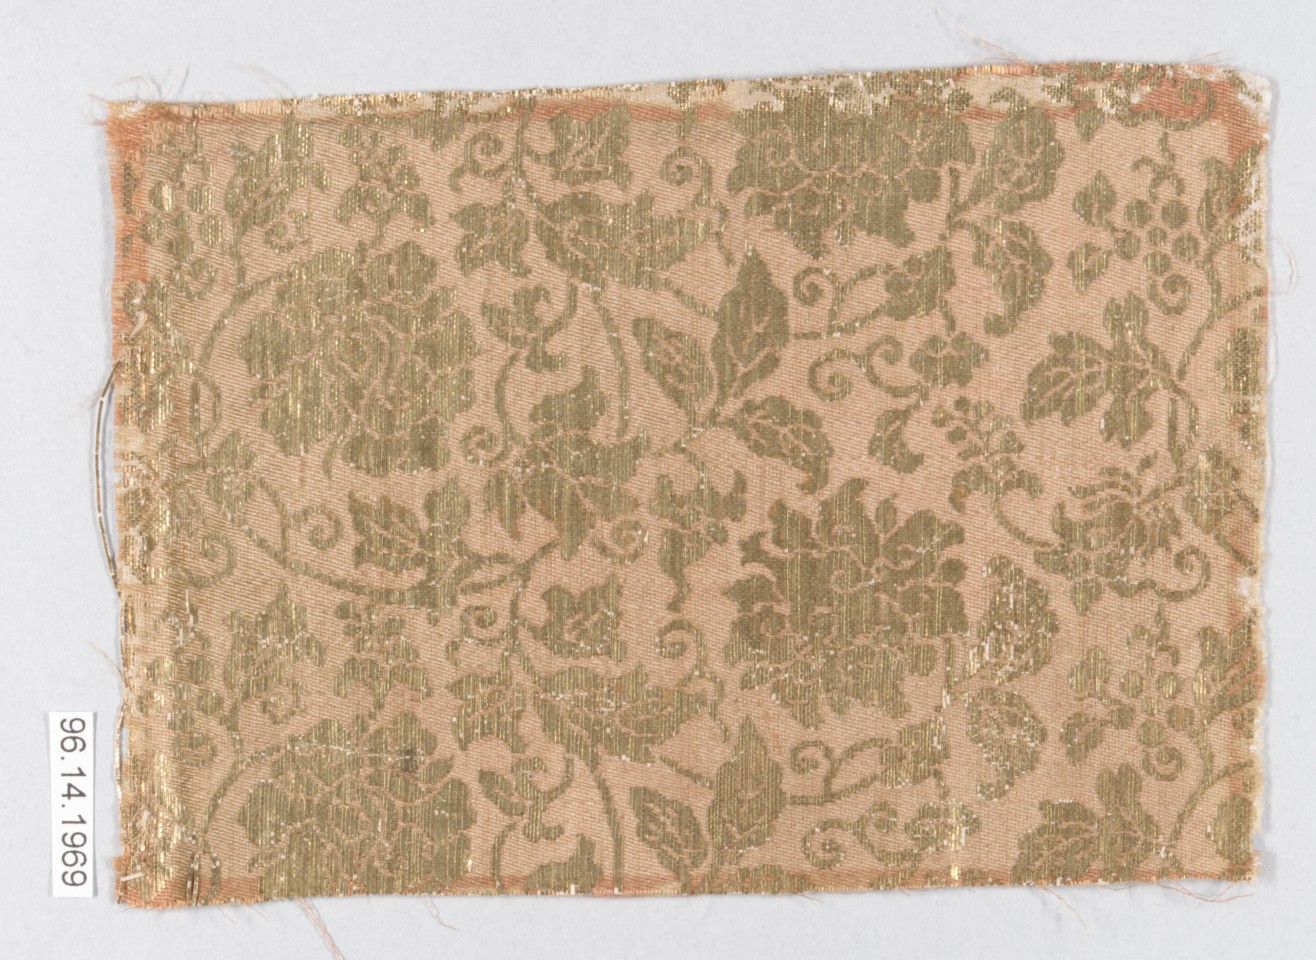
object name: piece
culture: japanese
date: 1701-1800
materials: metal thread, silk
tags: leaves